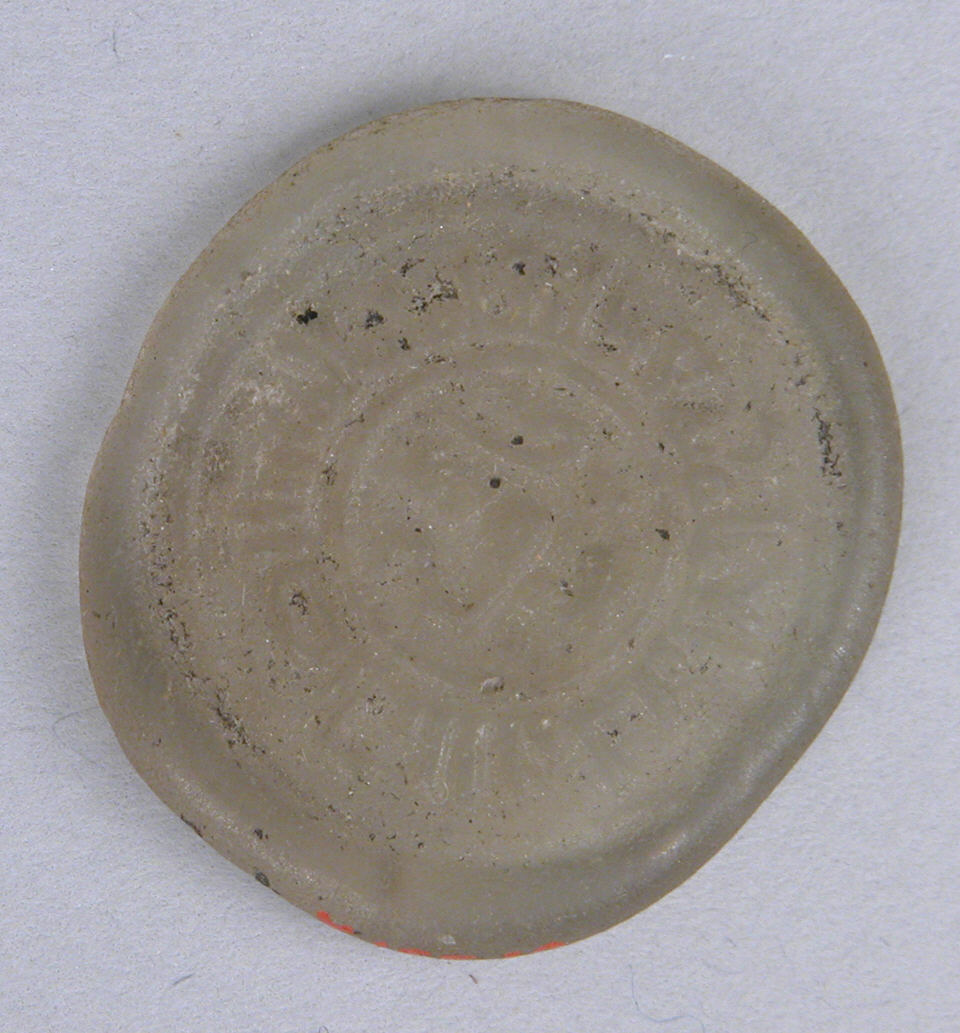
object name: coin weight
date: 1001-1100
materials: glass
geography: egypt